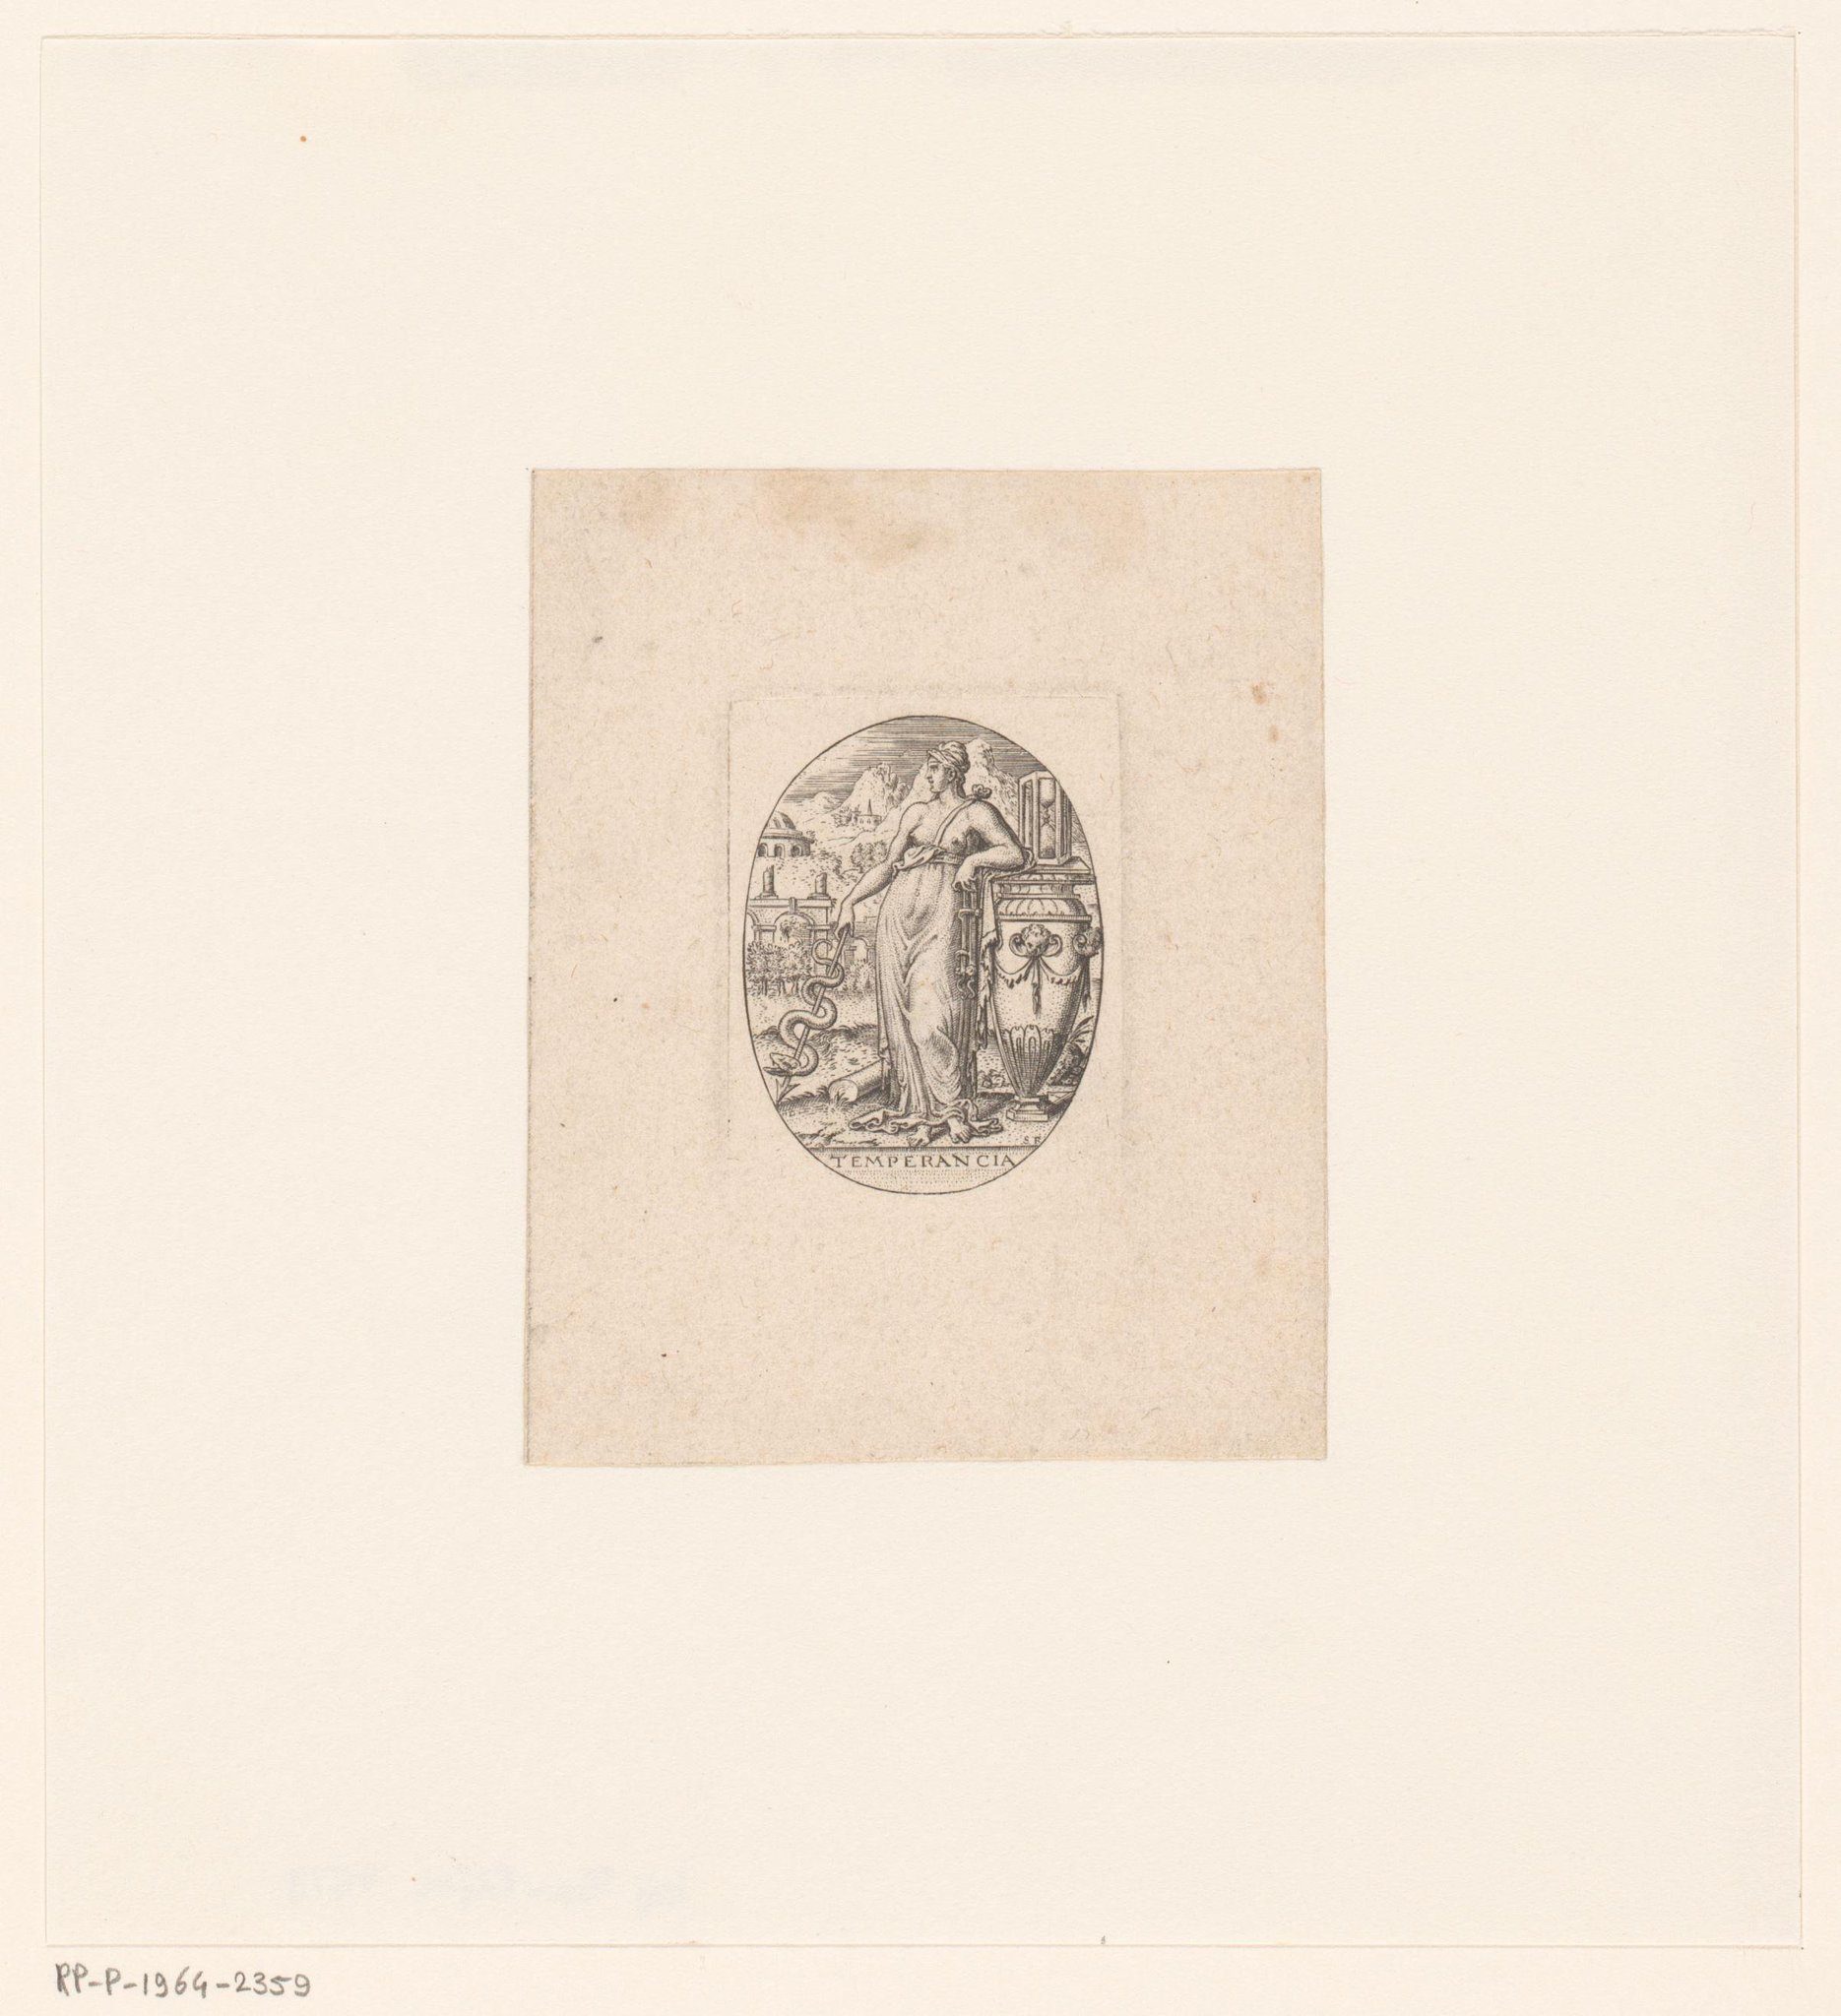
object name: print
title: Suite des Vertus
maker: etienne delaune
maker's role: draughtsman, goldsmith, print maker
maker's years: 1519-1583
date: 1569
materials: paper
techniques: engraving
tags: temperance, 'temperantia'; 'temperanza' (ripa) ~ one of the four cardinal virtues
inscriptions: collector's mark: Lugt 2228, collector's mark: Lugt 1723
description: Maakt deel uit van negendelige serie met personificaties van de deugden in ovale vorm.